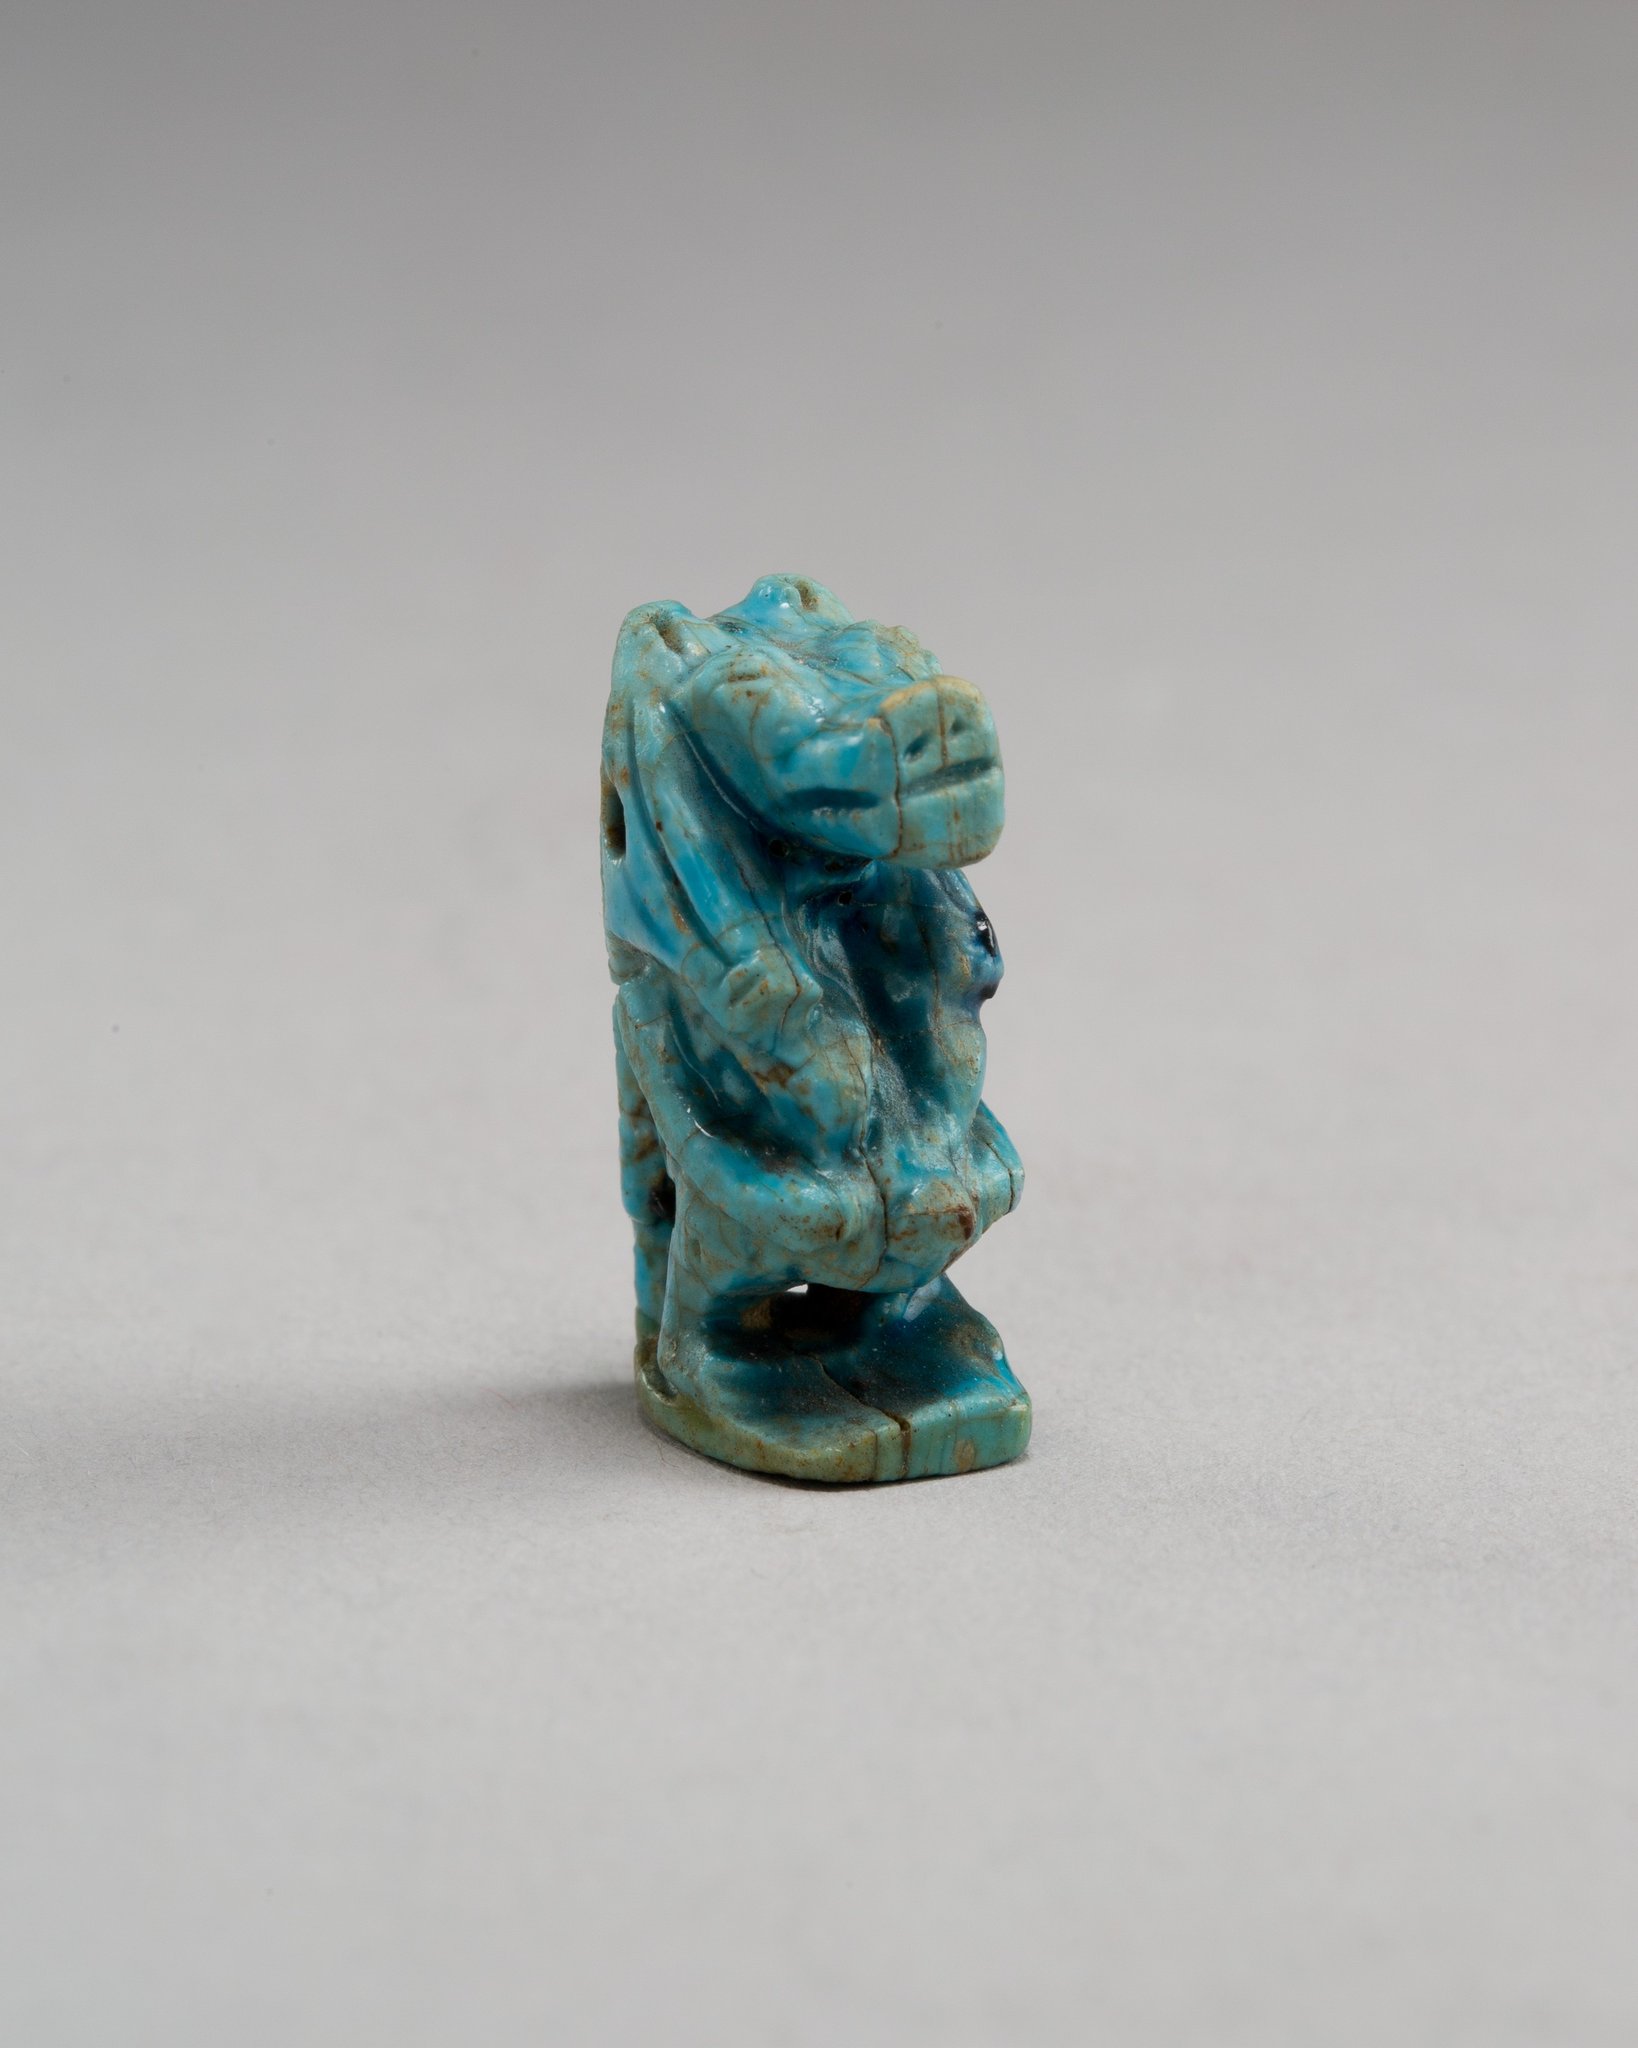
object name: amulet, taweret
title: Taweret amulet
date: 664-332 BCE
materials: faience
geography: greece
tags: taweret